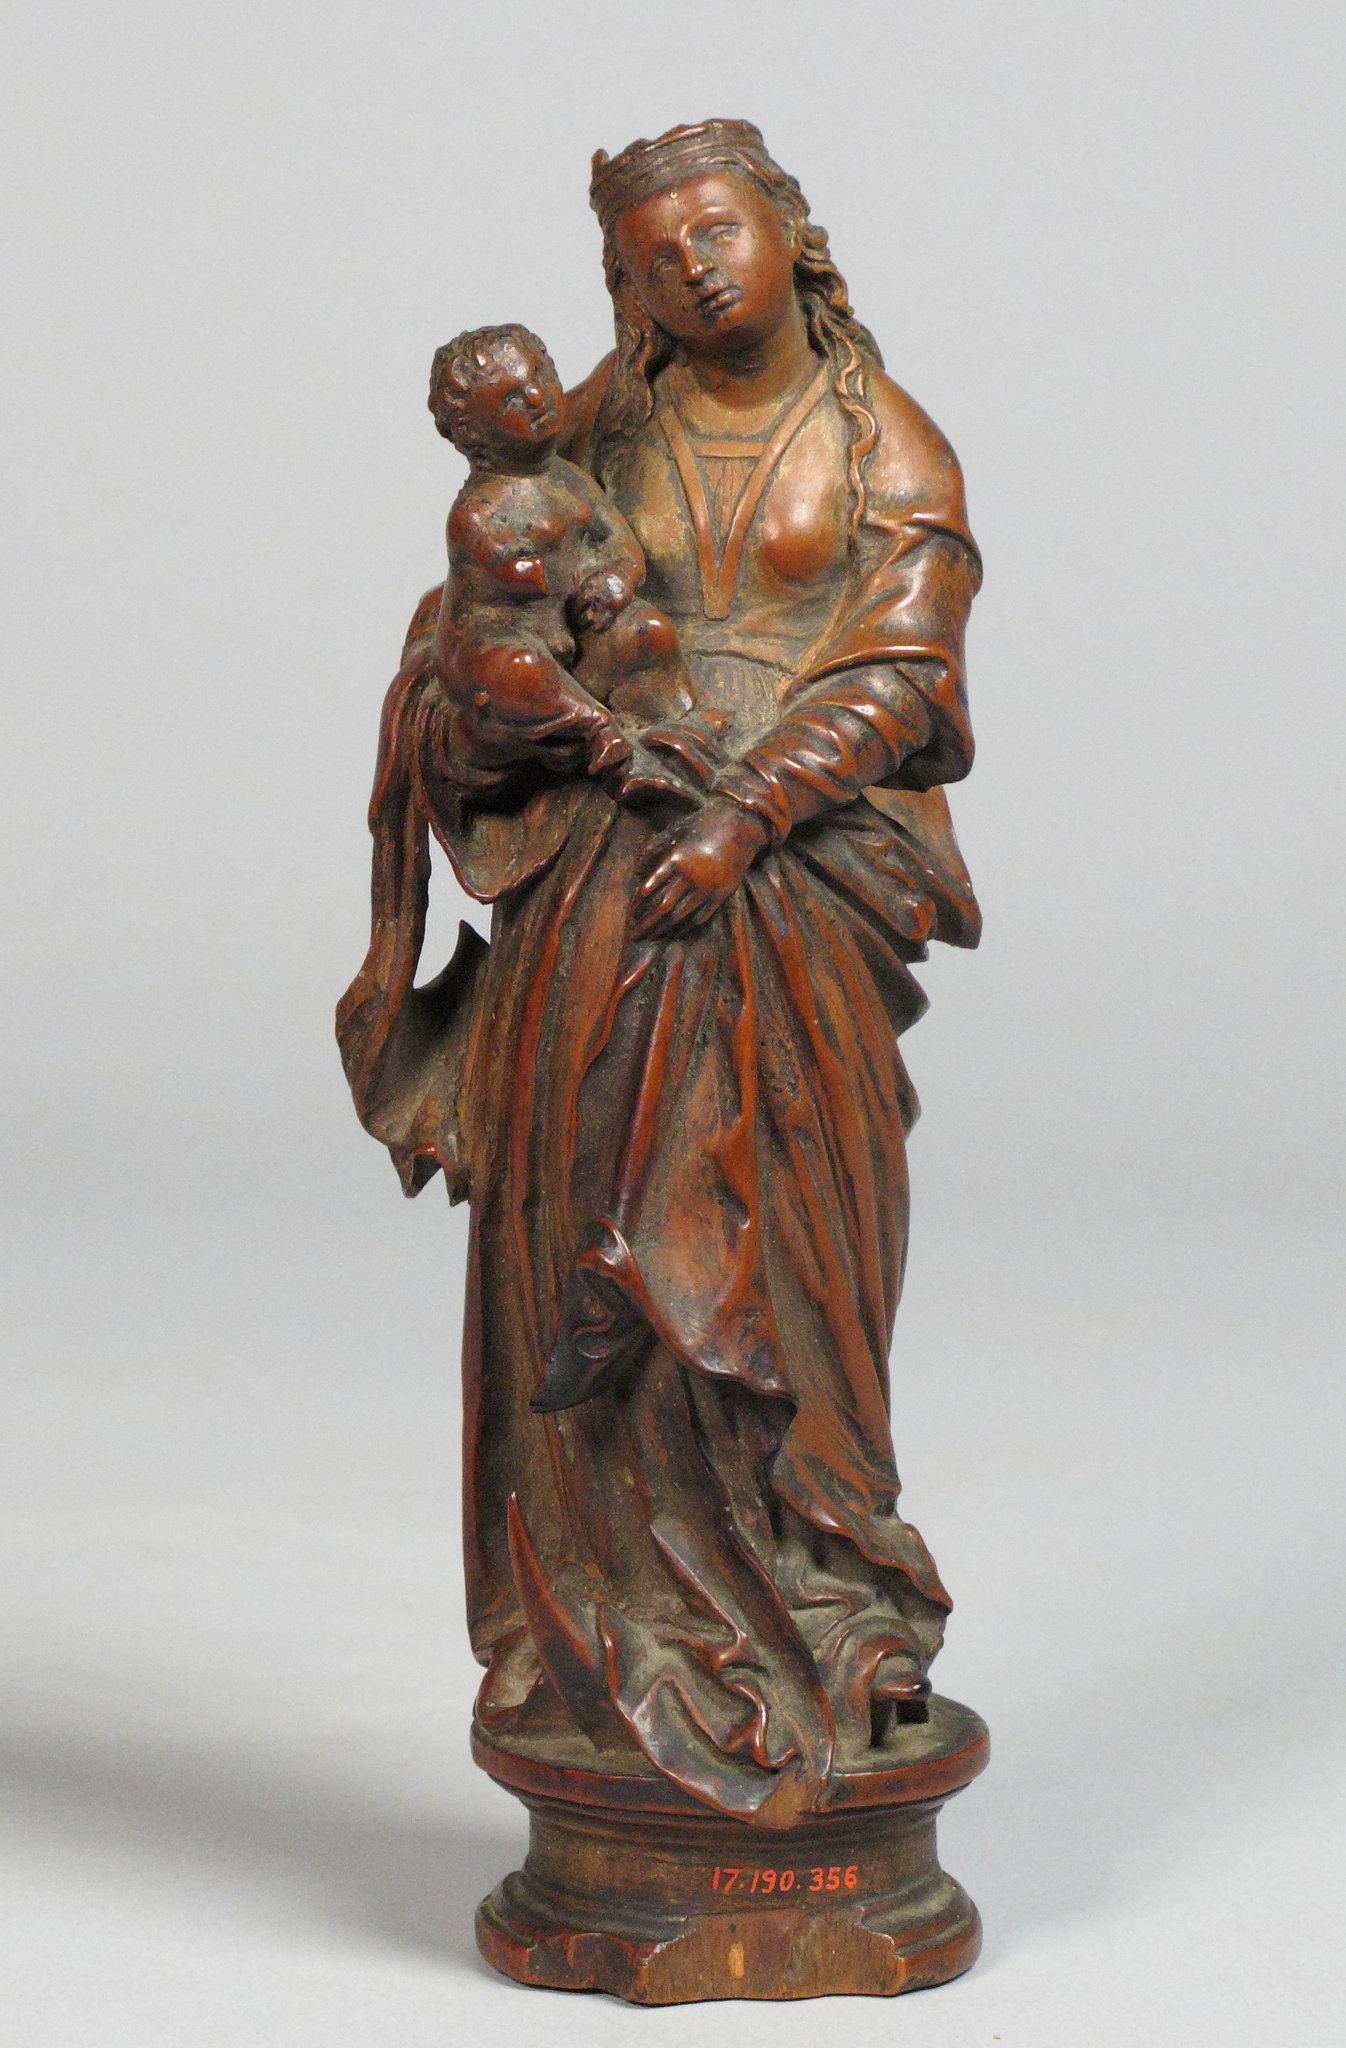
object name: statuette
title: Virgin and Child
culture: south netherlandish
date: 1501-1600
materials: wood